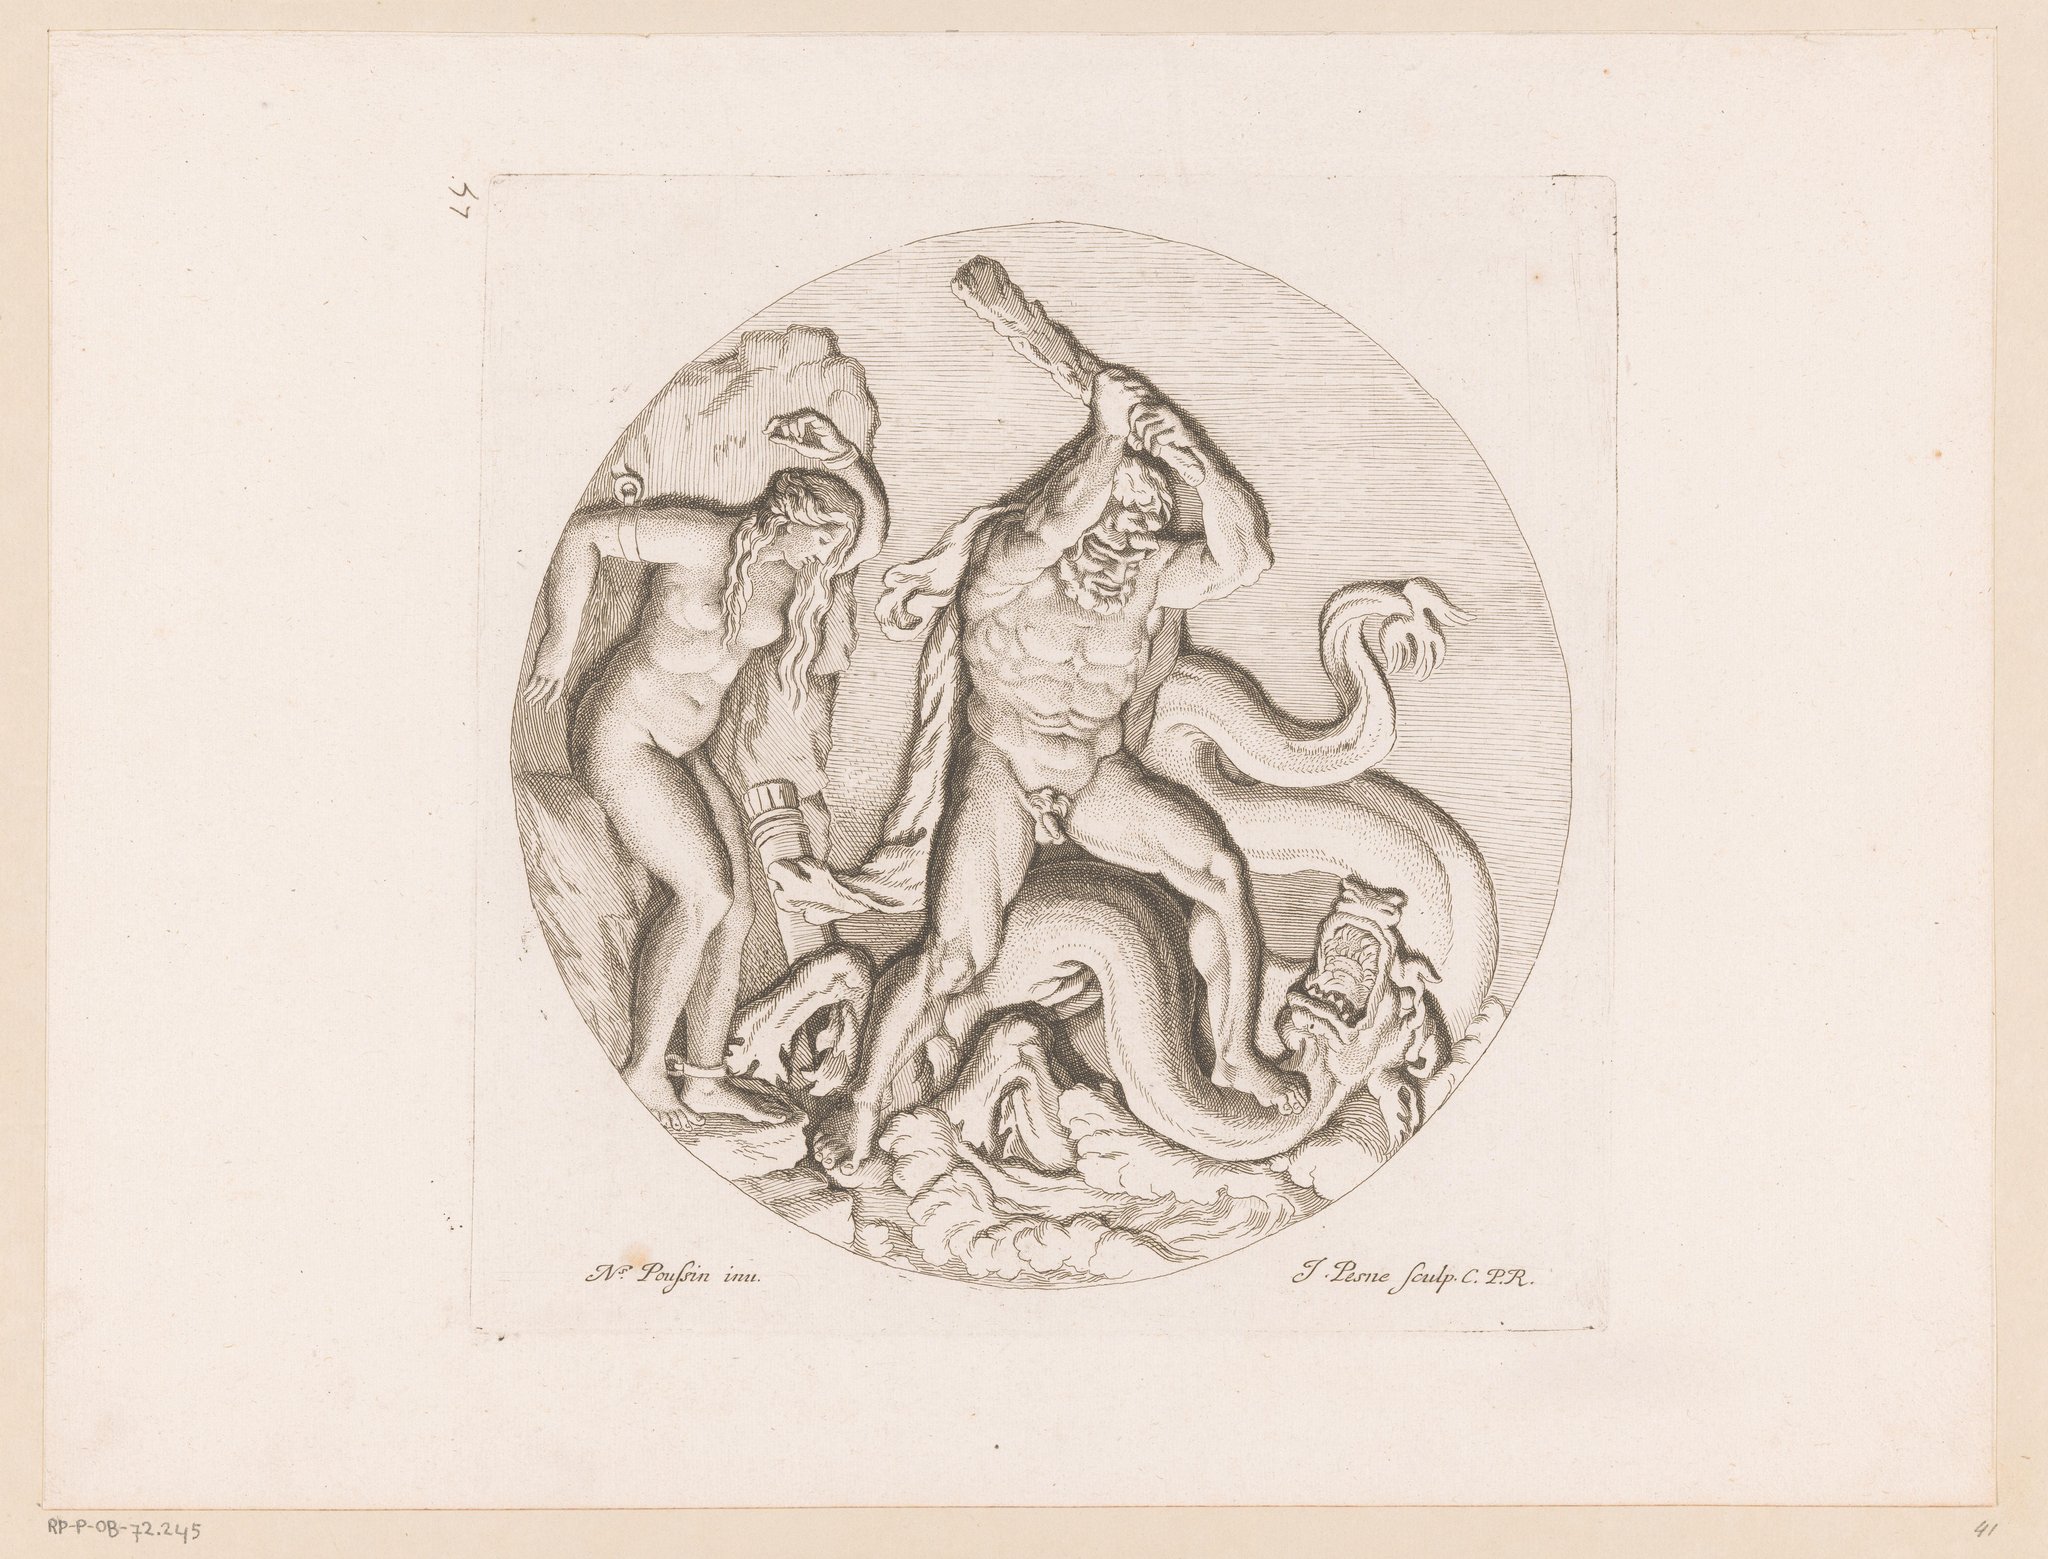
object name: print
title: Hercules bevrijdt Hesione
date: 1678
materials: paper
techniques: engraving, etching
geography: france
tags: hercules liberates hesione, laomedon's daughter, by killing the sea monster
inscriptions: collector's mark: Lugt 240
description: Prent maakt deel uit van een ongenummerde serie van negentien prenten.